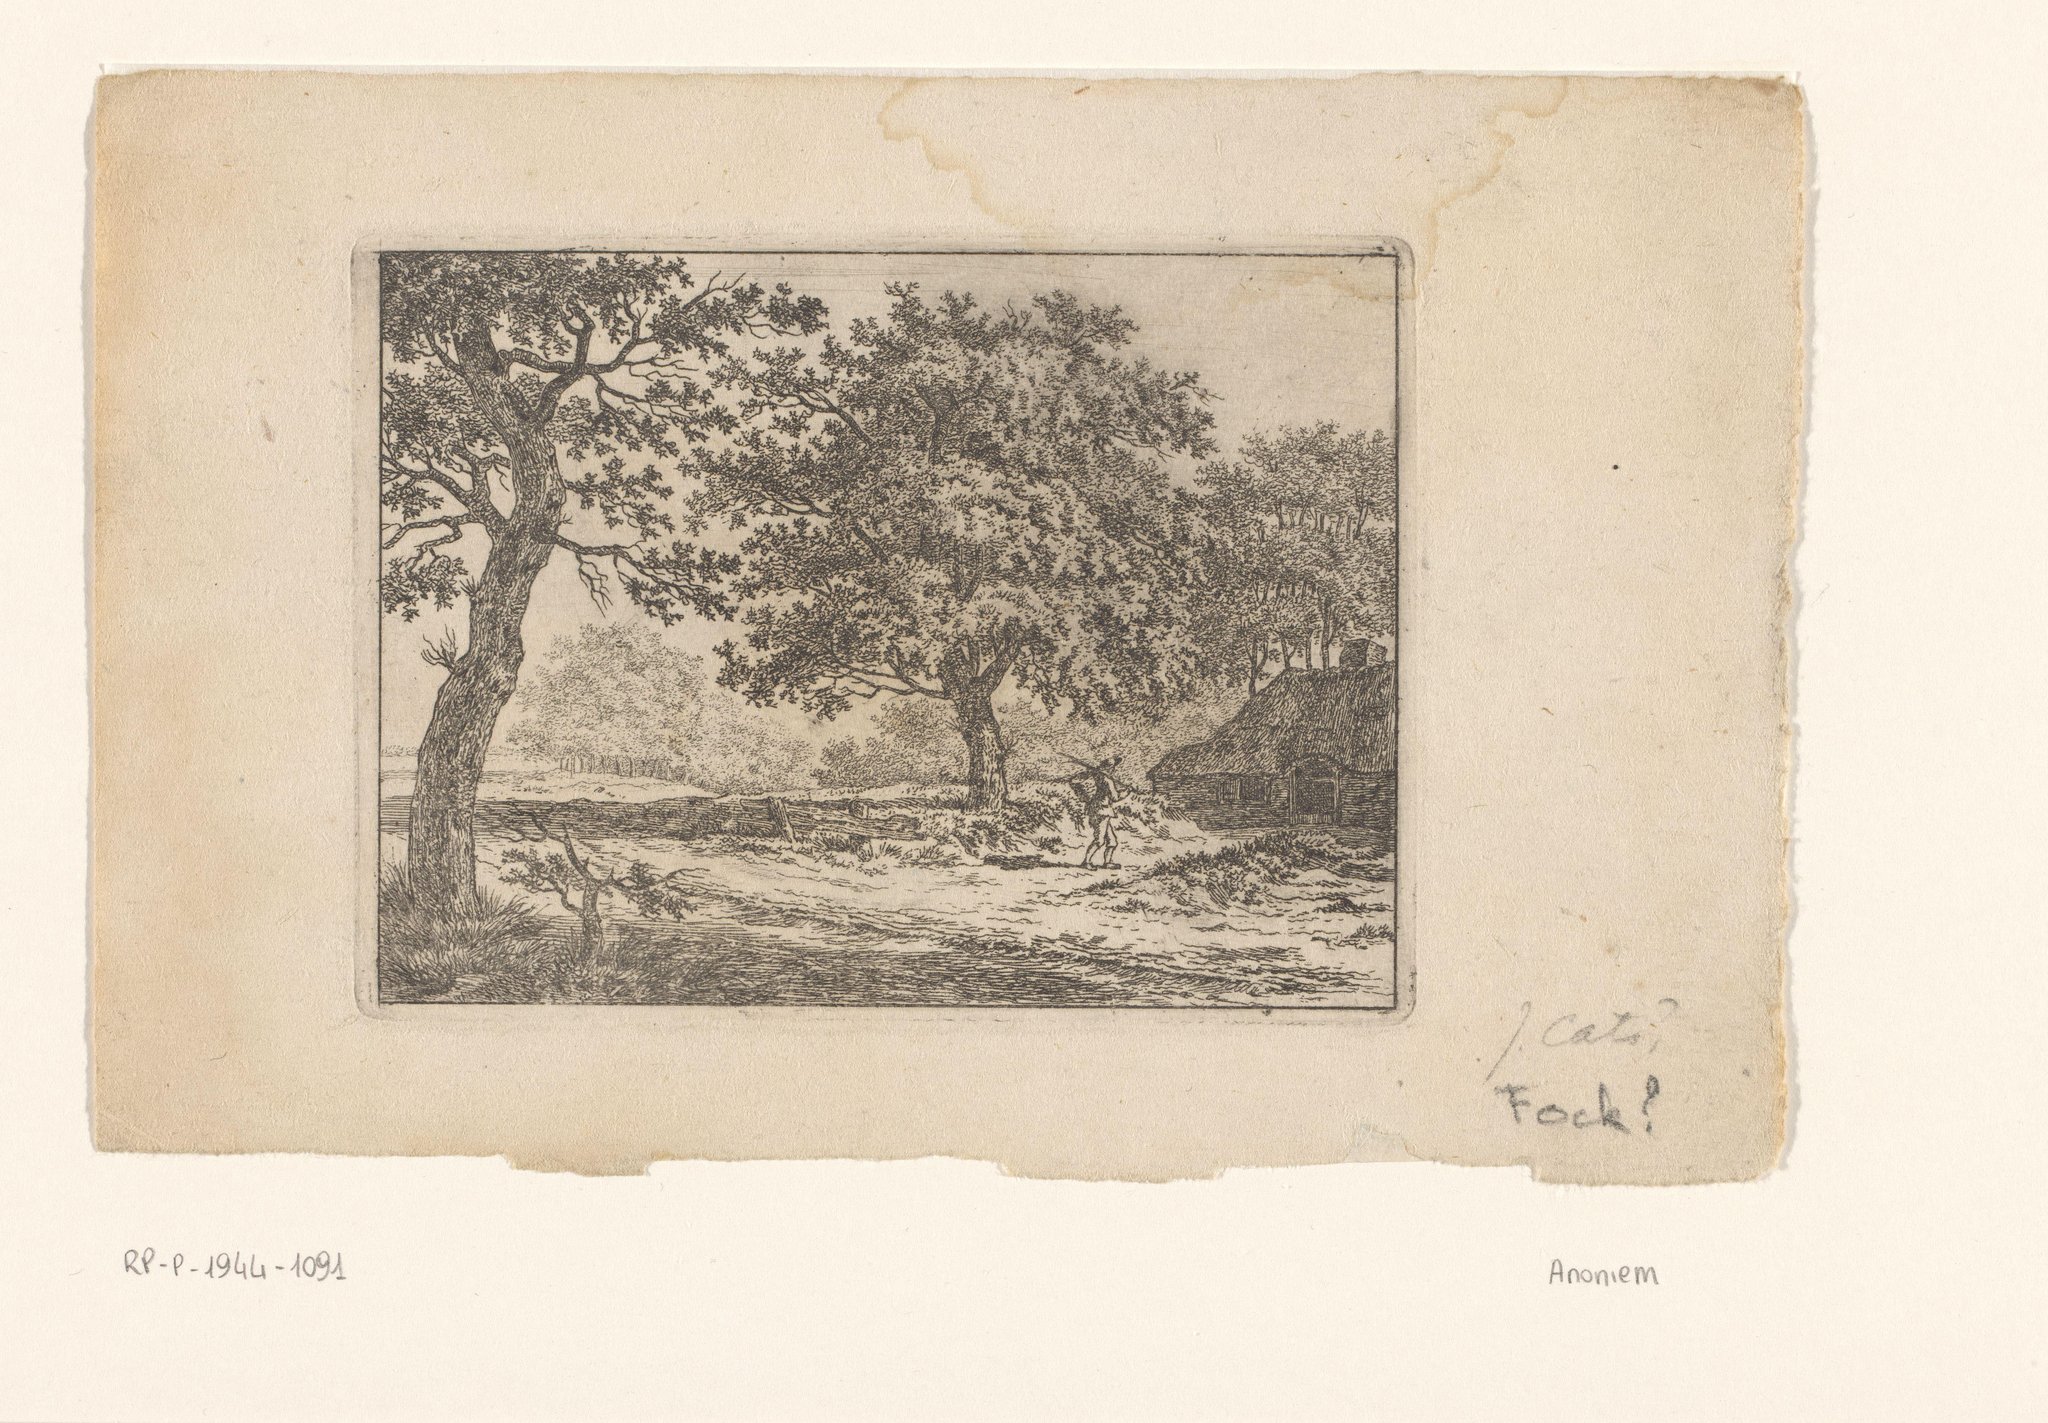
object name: print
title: Figuur met mand op een landweg langs een boerderij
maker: Anonymous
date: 1720-1799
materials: paper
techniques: etching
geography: netherlands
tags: trees, farm or solitary house in landscape (+ city(-scape) with figures, staffage)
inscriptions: collector's mark: Lugt 2228